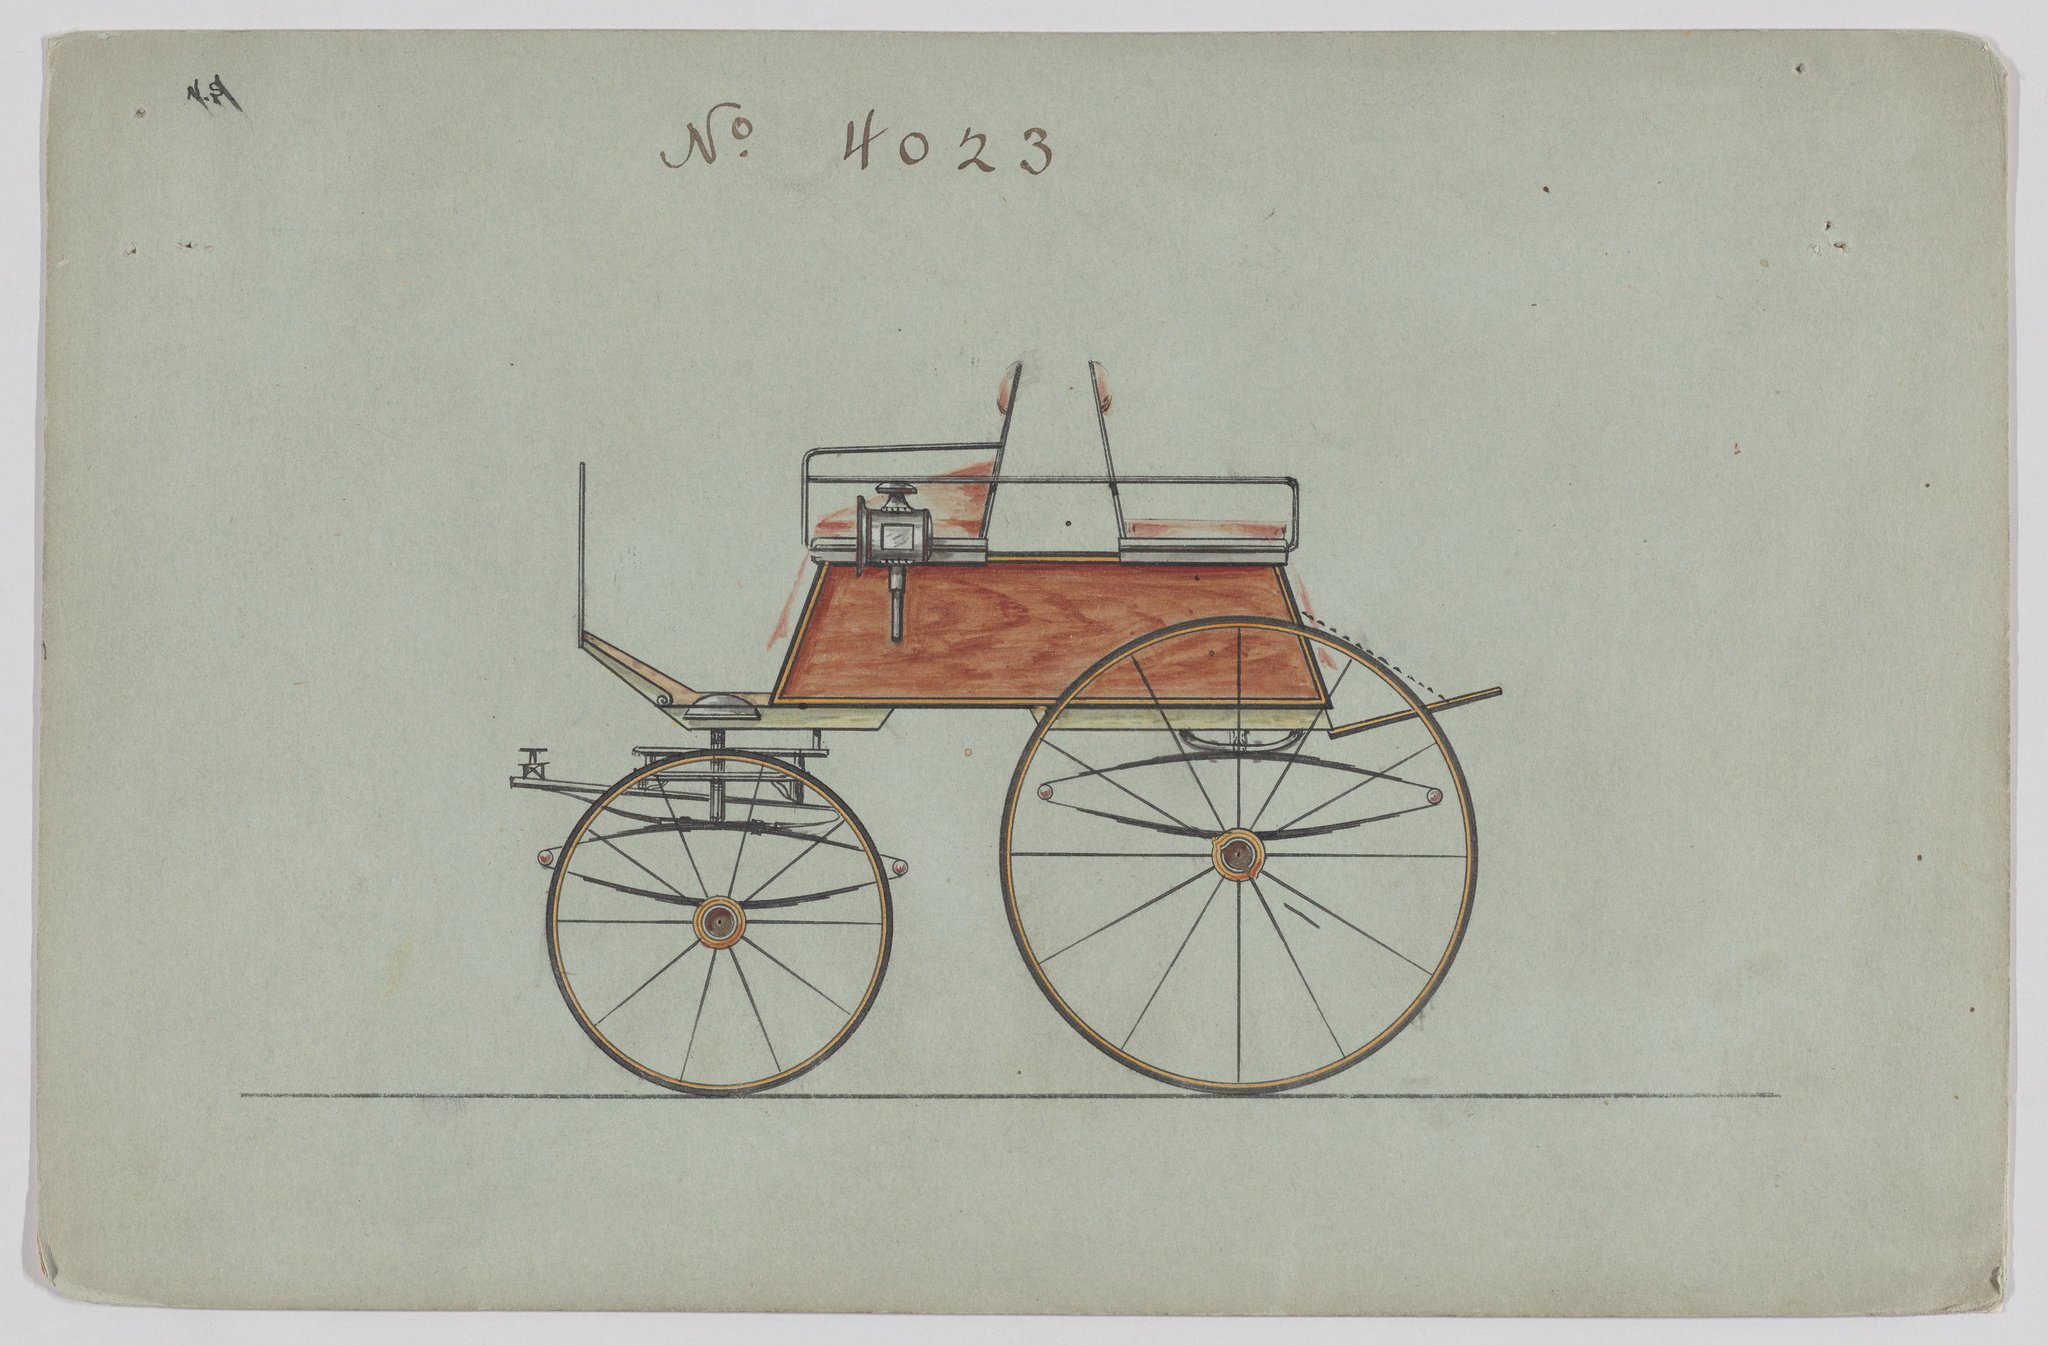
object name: drawing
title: Four Wheel Dog Cart #4023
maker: brewster & co.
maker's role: manufacturer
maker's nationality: american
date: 1888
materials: gouache, ink, watercolor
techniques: pen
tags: carriages